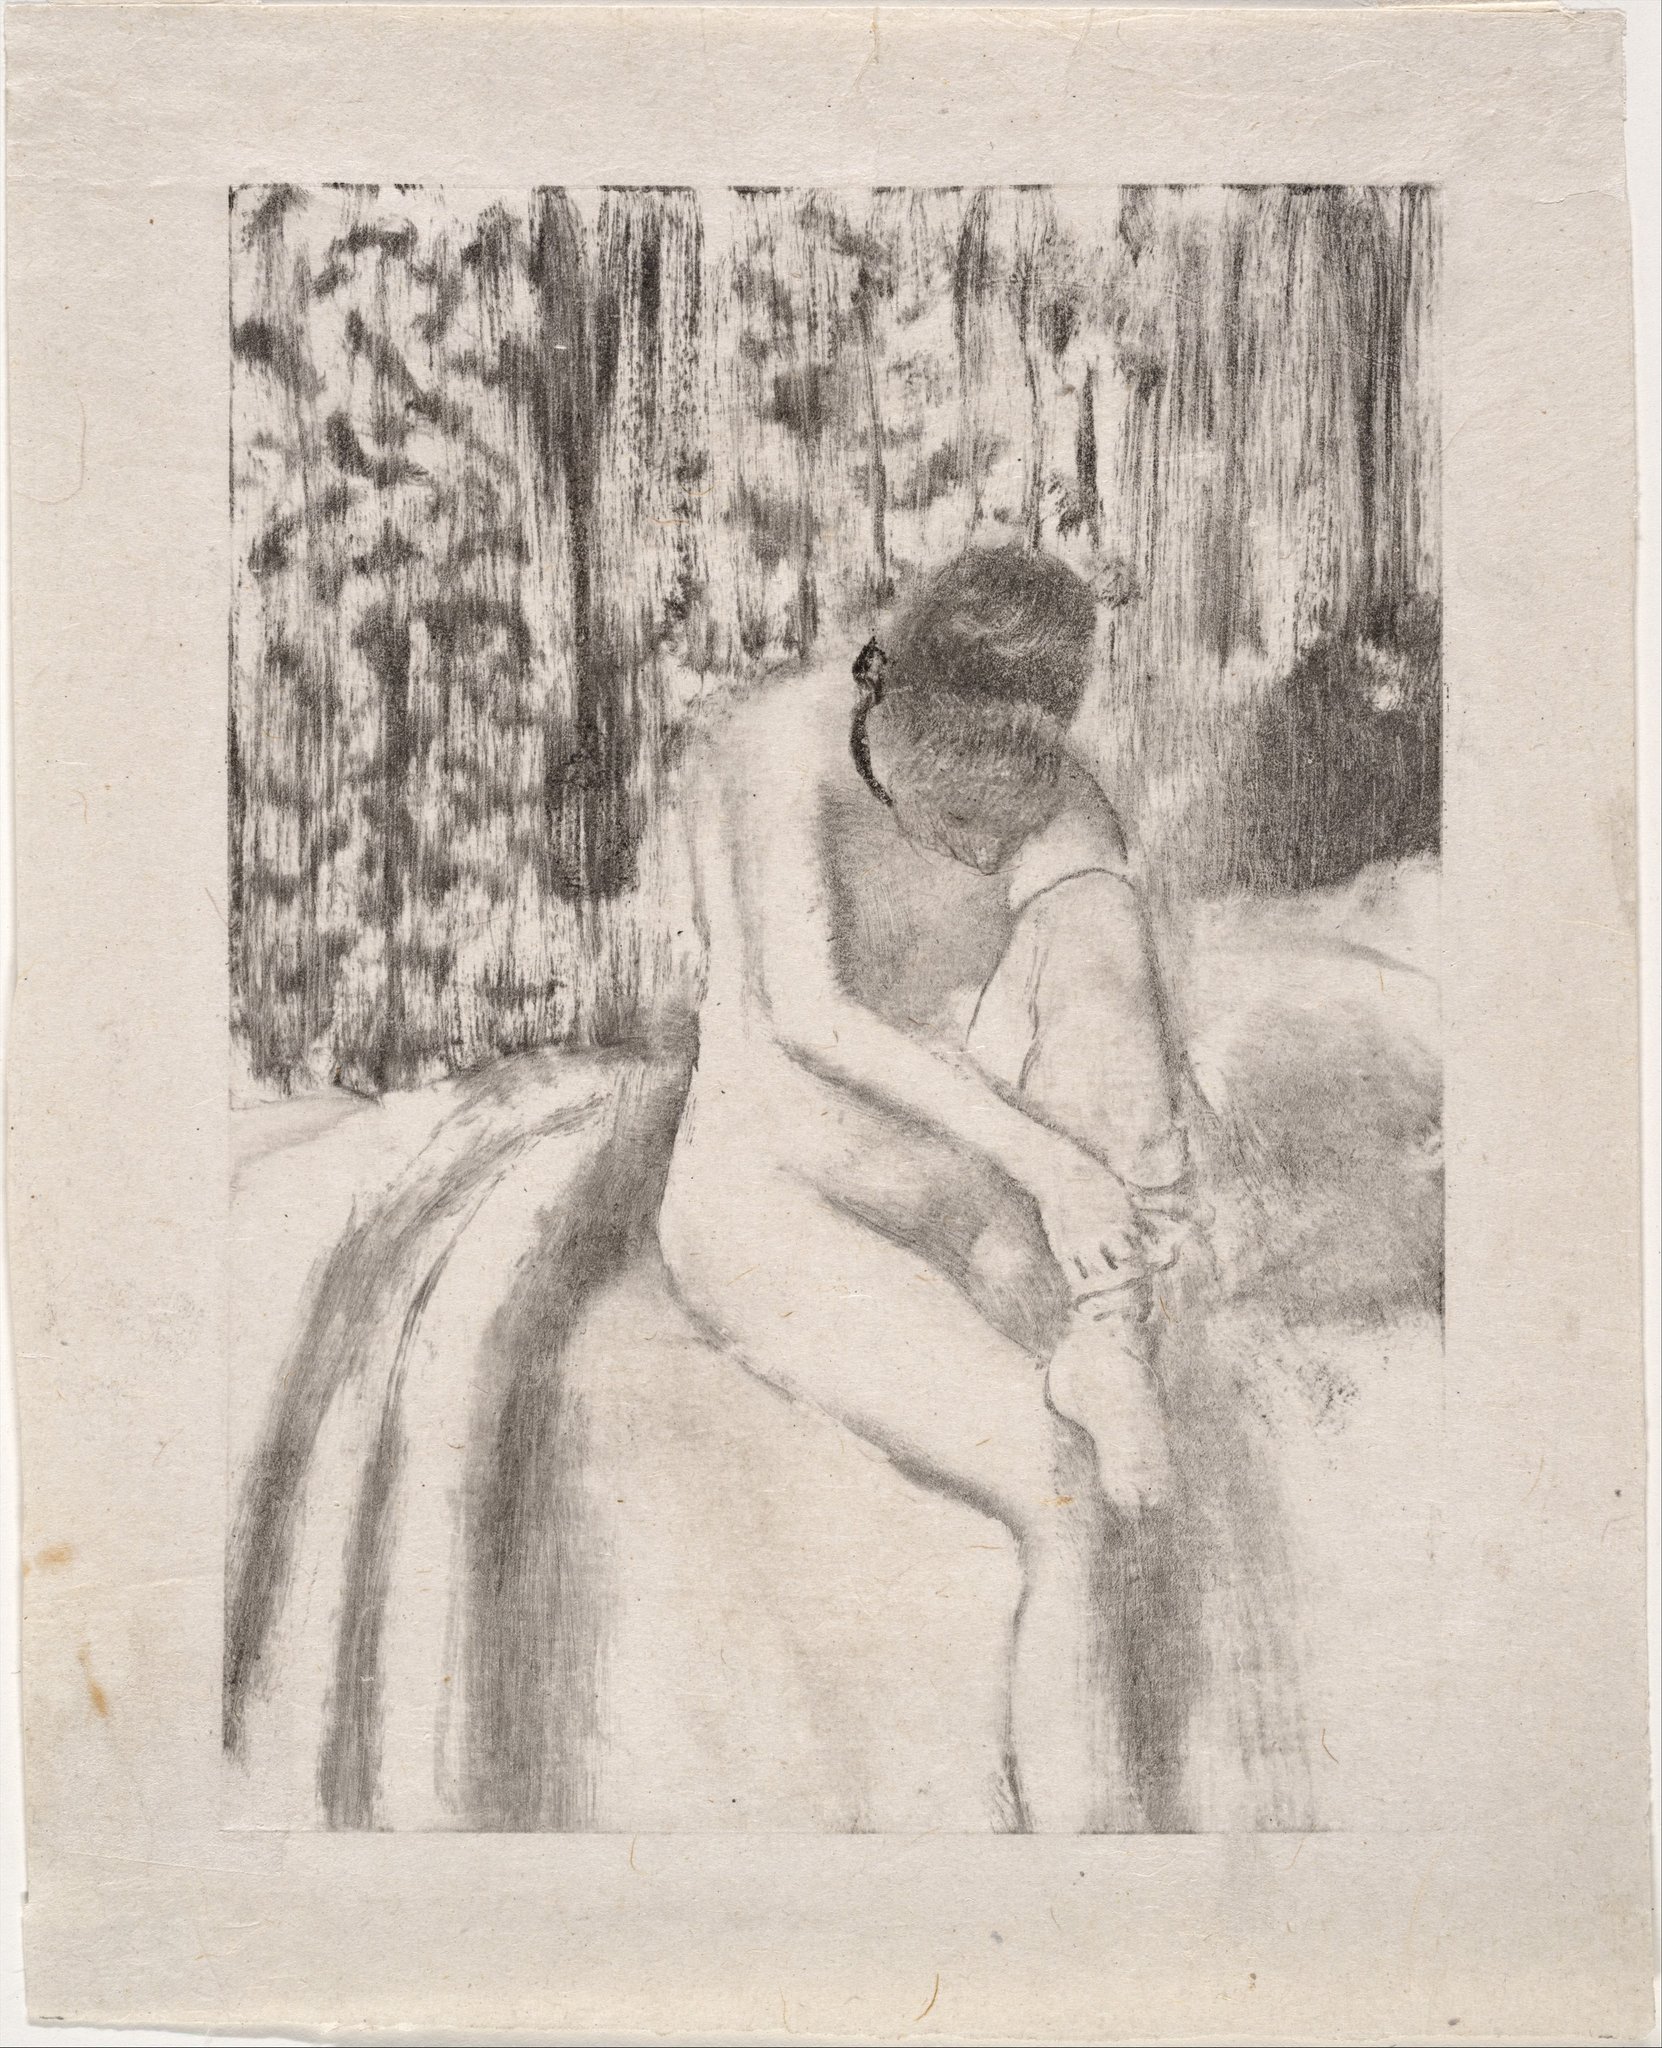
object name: print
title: Girl Putting on Her Stockings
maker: edgar degas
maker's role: artist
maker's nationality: french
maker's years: 1834-1917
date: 1876-1877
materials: cardboard, paper, ink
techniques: printing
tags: female nudes